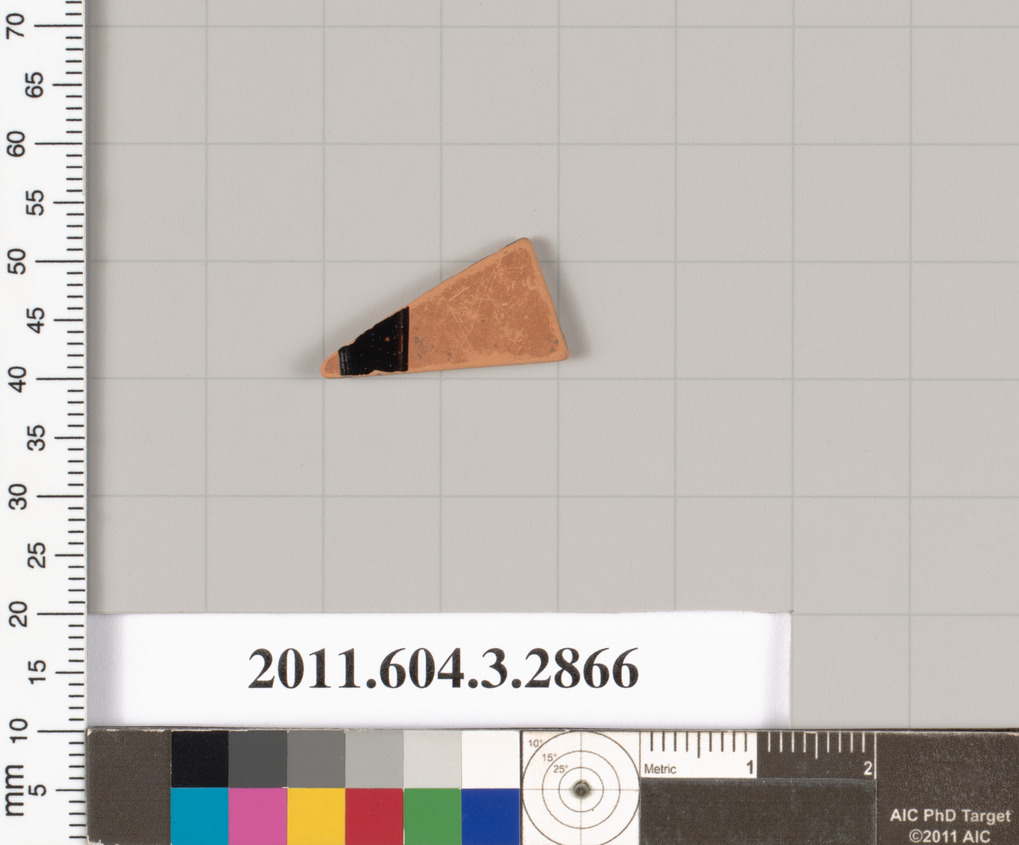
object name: undetermined shape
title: Terracotta fragment of an undetermined shape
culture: greek, attic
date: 600-401 BCE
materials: terracotta